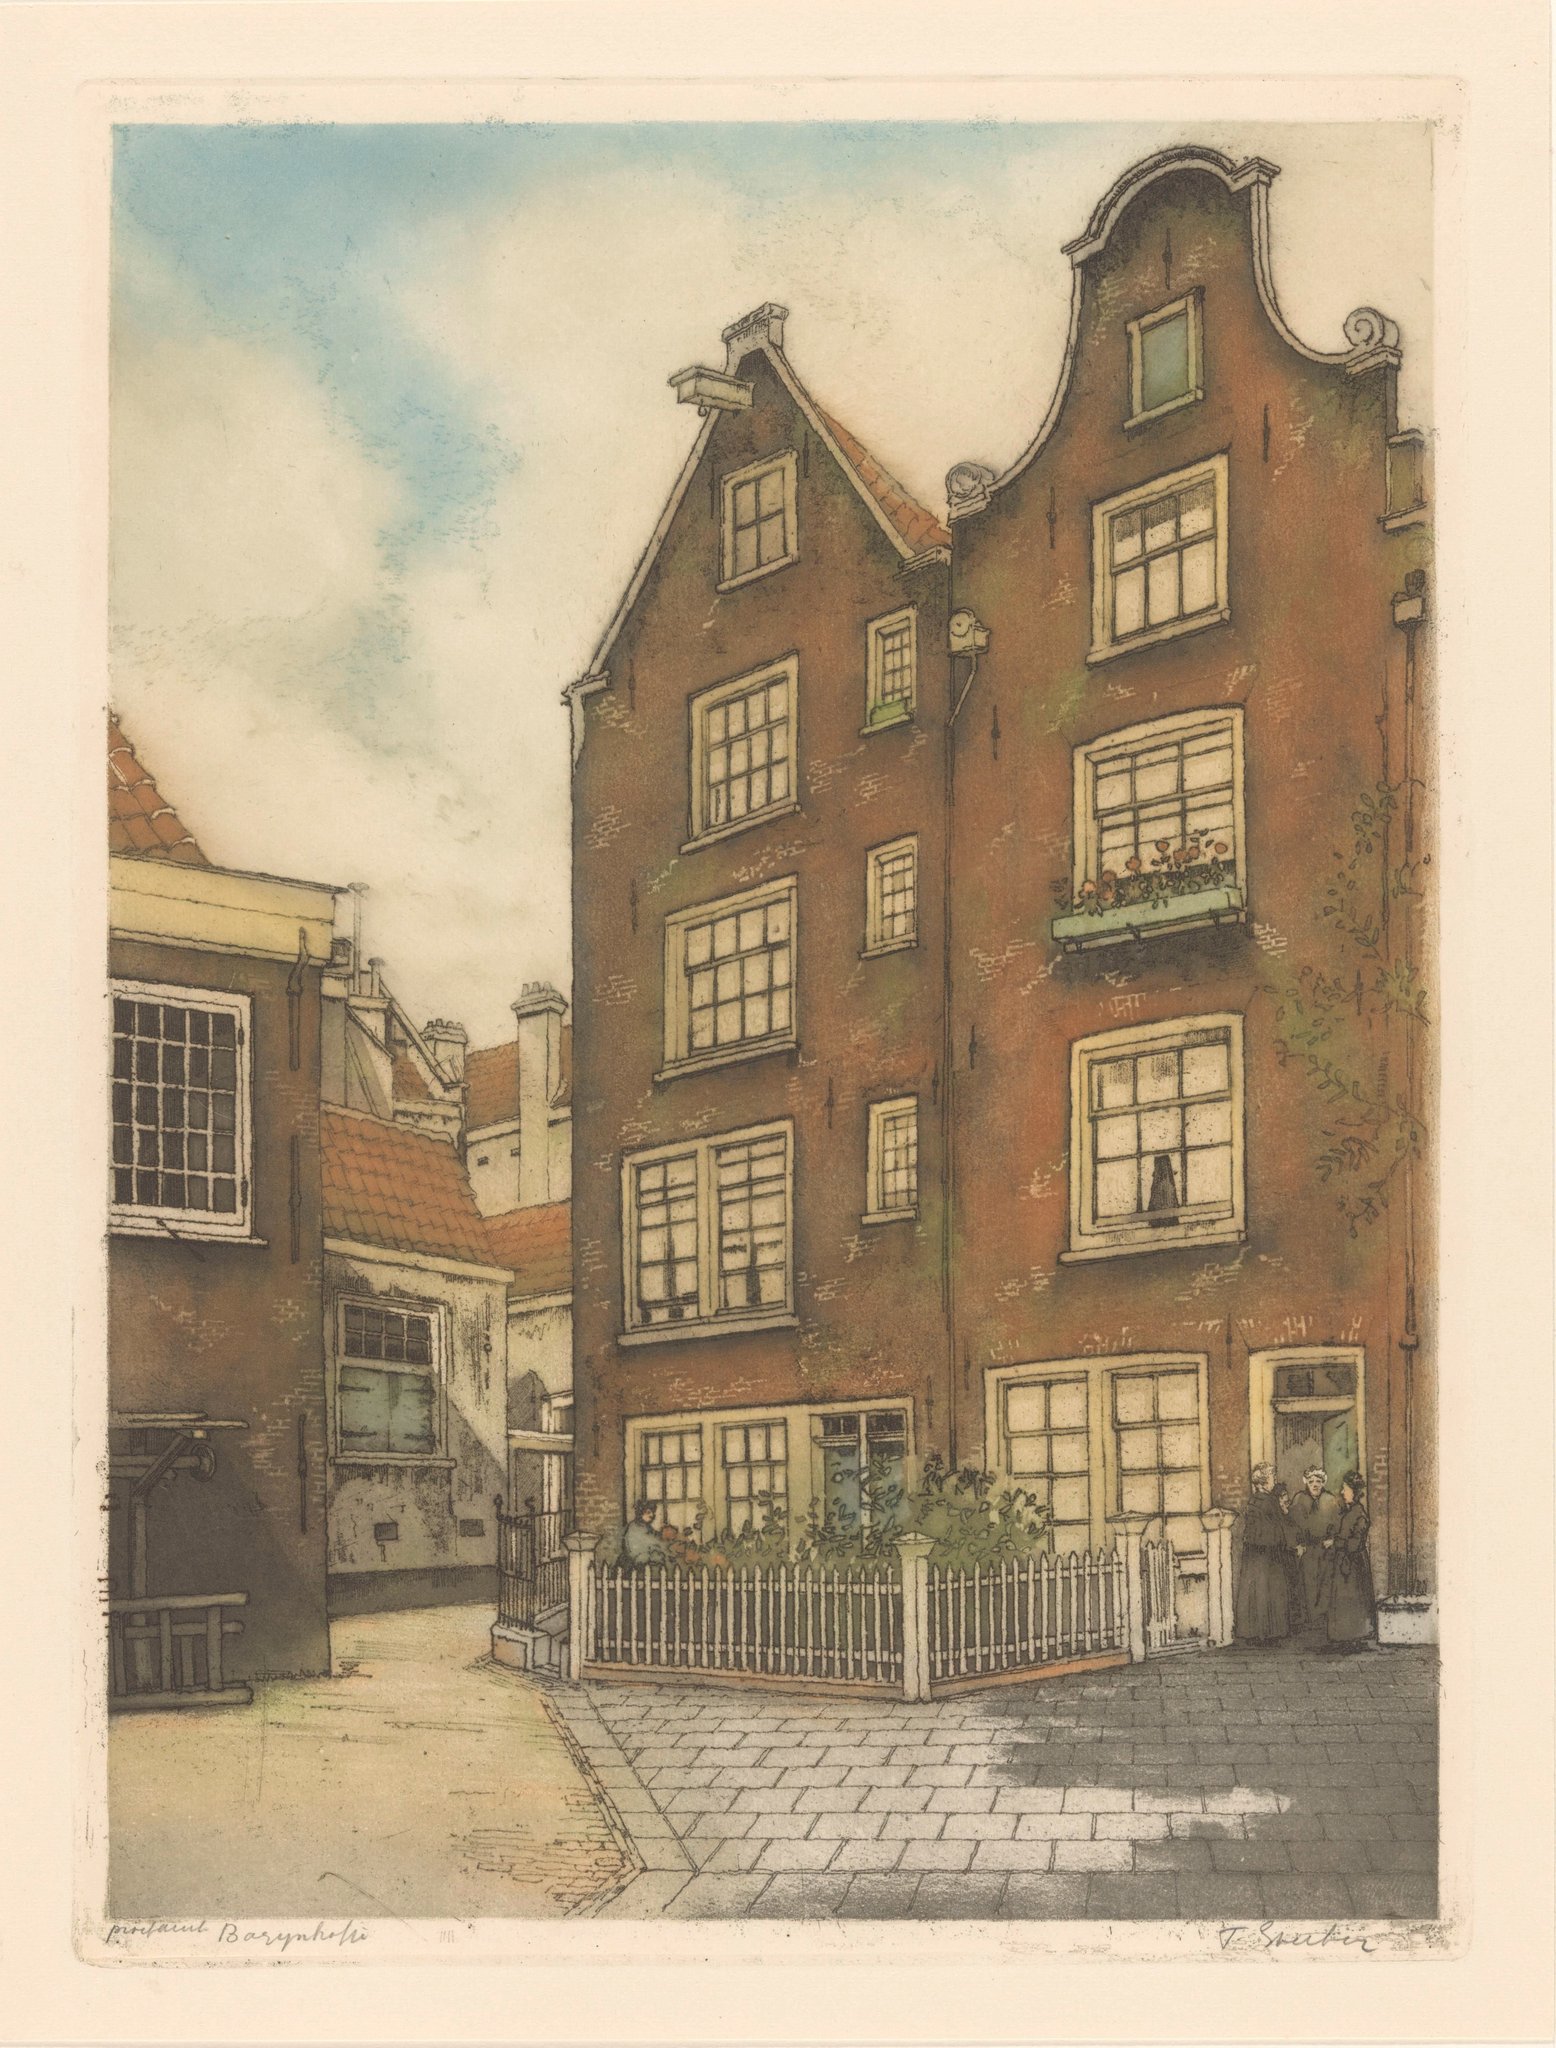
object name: print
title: Bagijnhofje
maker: frans everbag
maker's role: draughtsman, print maker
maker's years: 1877-1947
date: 1887-1931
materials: paper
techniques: aquatint, etching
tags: beguines, courtyard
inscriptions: collector's mark: Lugt 2228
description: Begijnen in gesprek bij de voordeur van een huis aan het Begijnhof in Amsterdam.